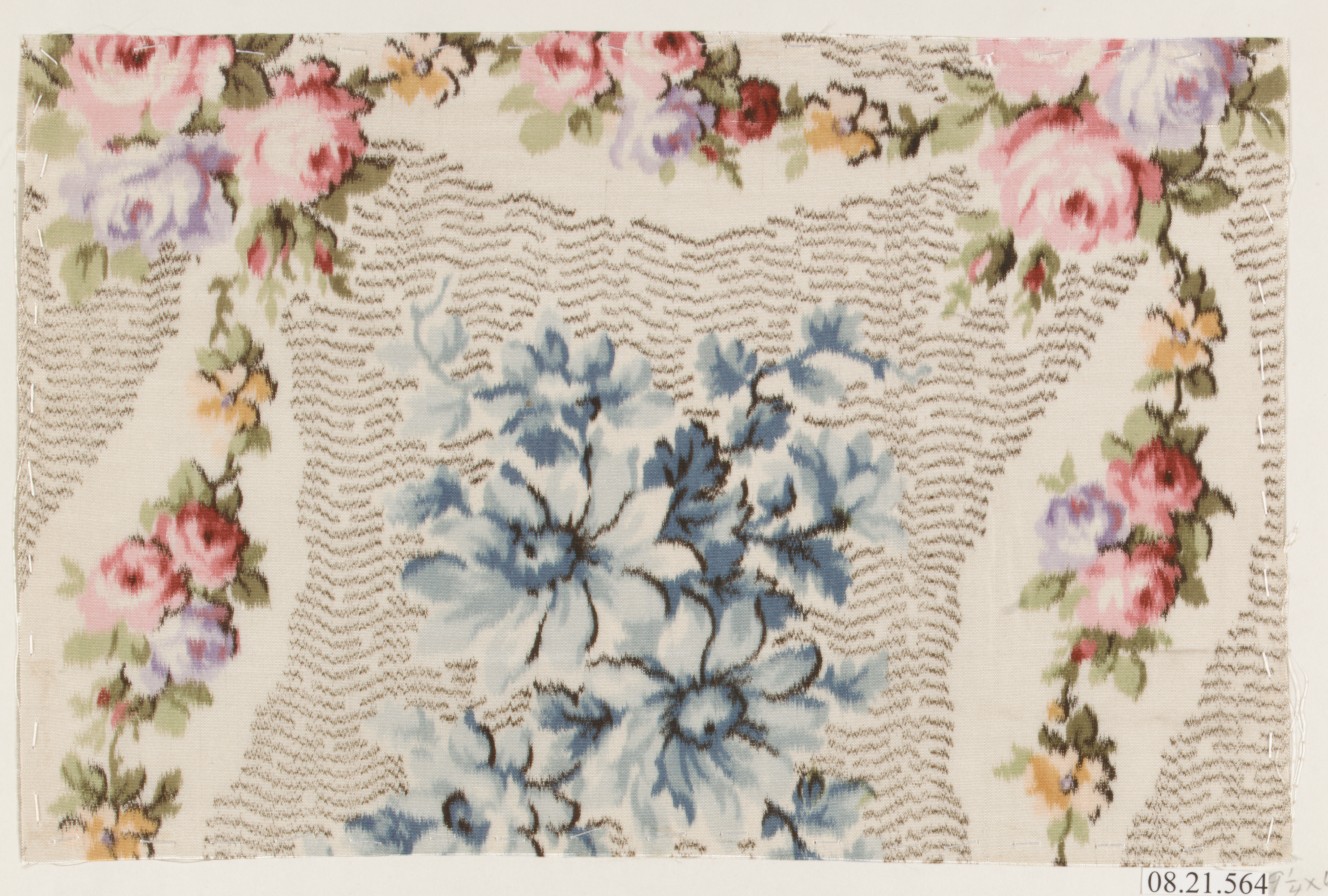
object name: textile sample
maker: Anonymous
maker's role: designer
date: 1900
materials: silk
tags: flowers